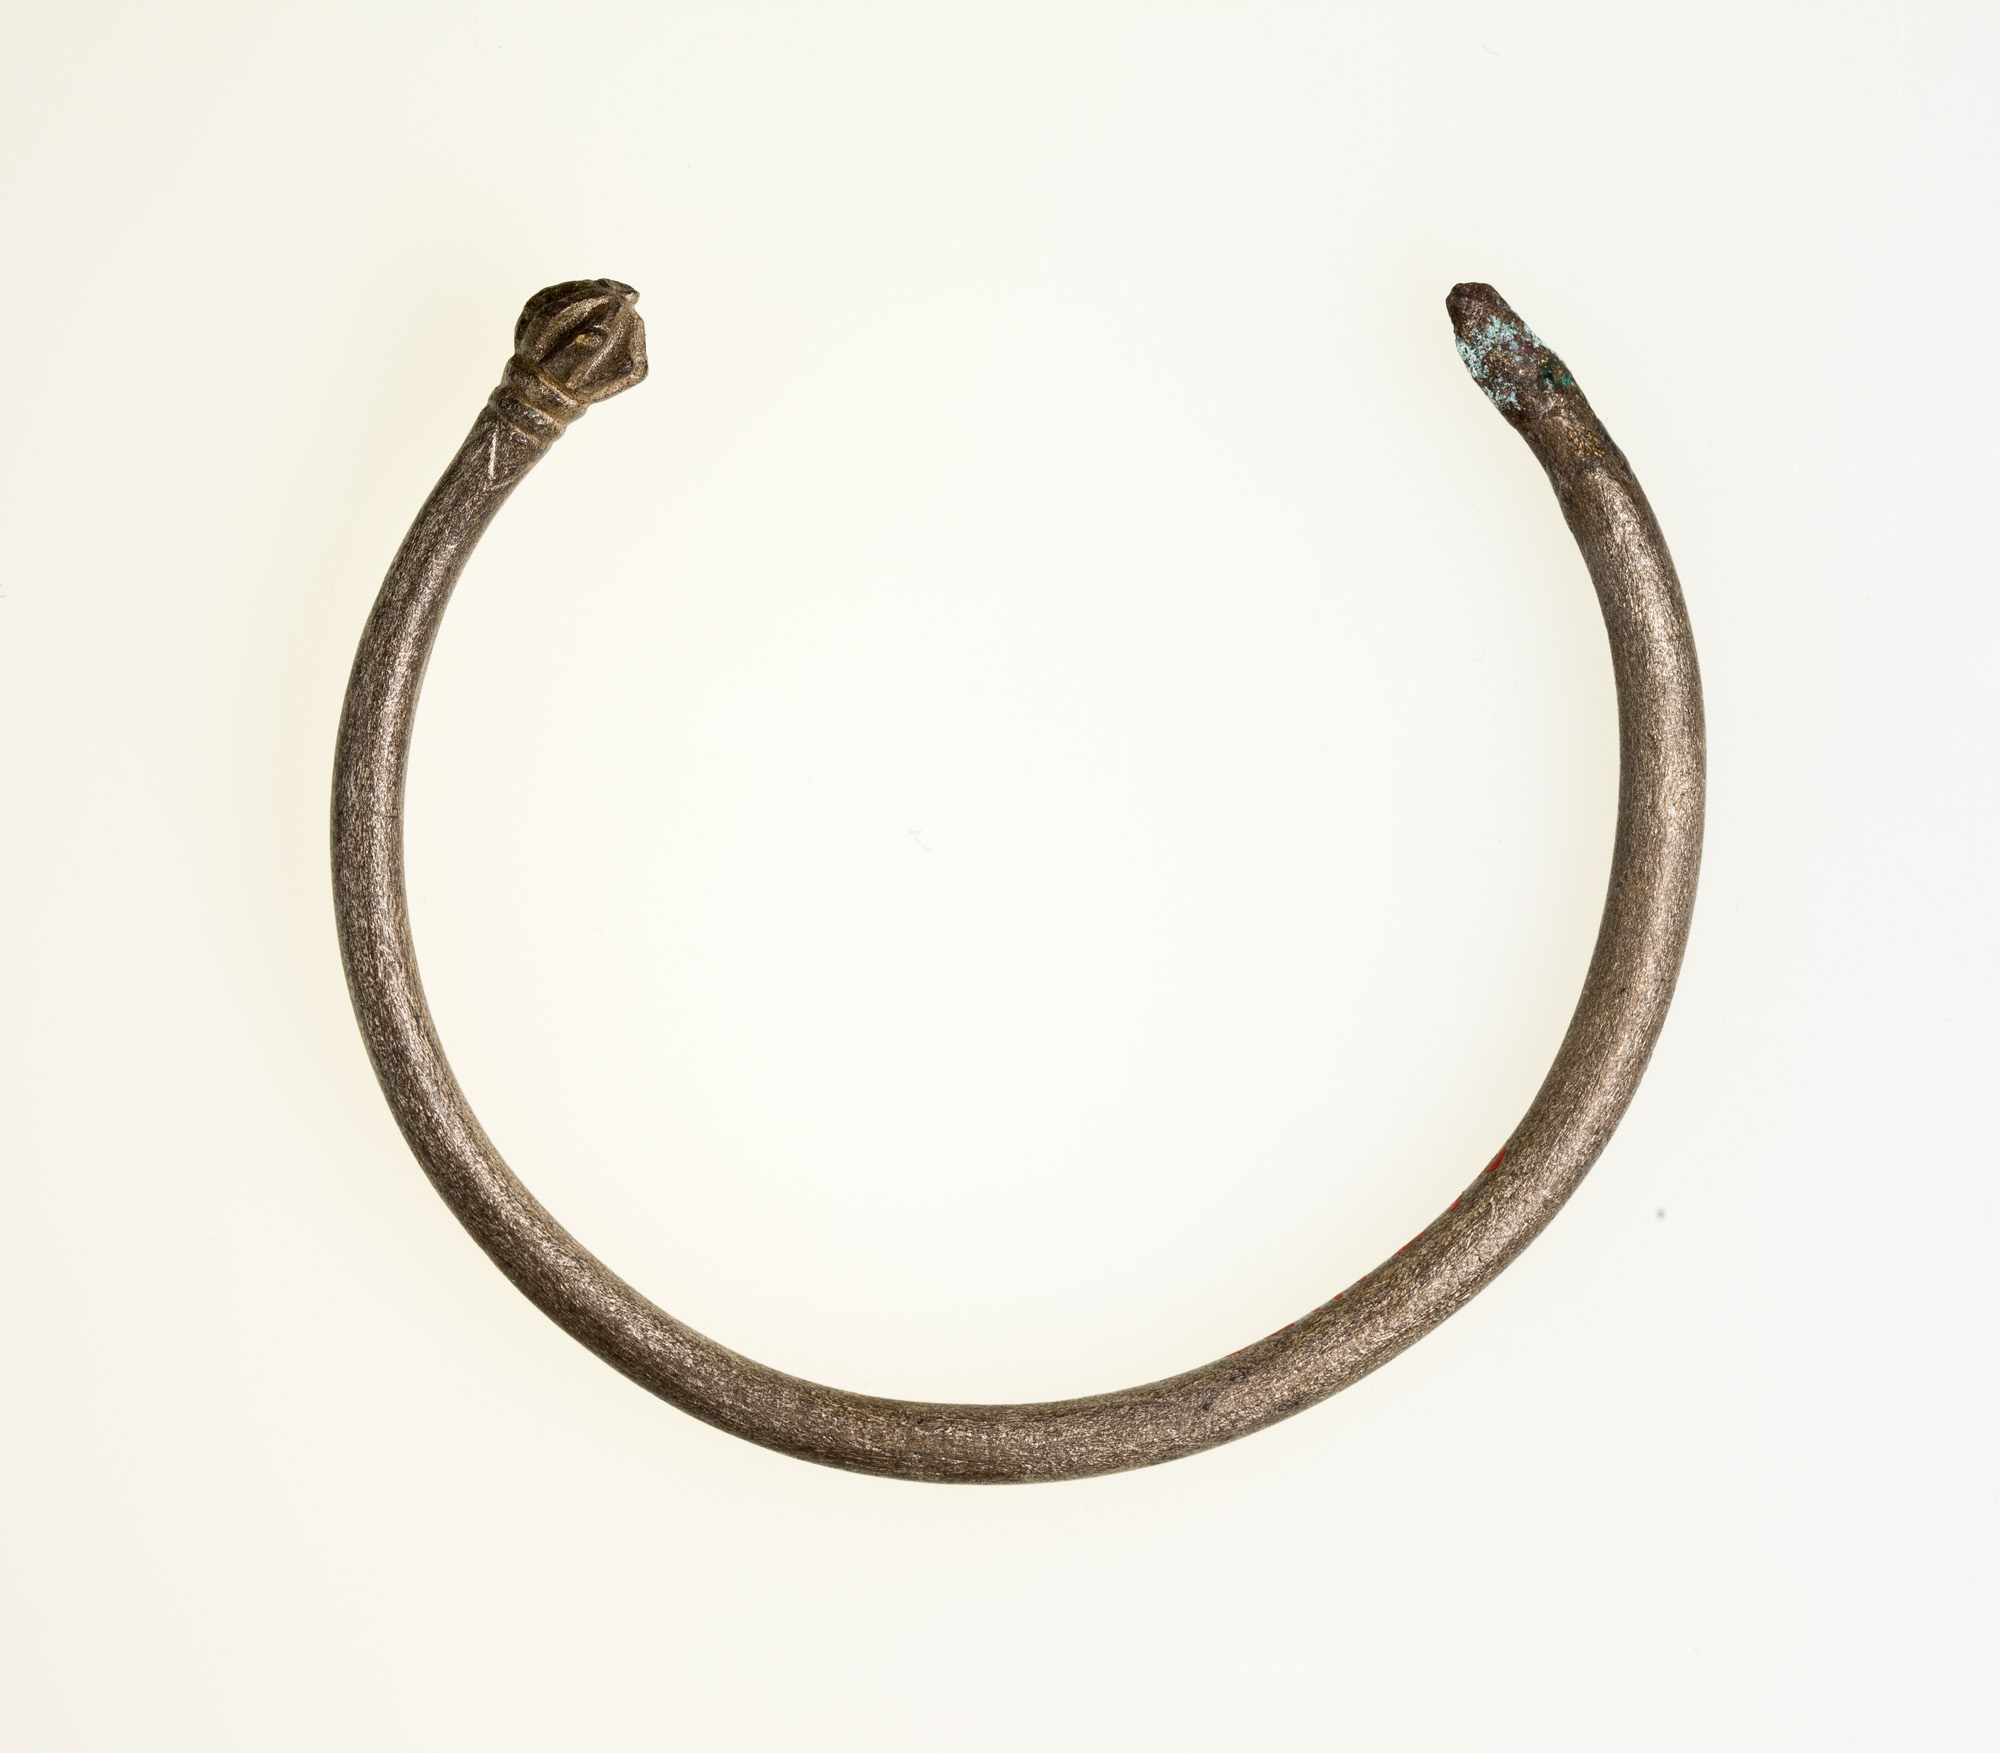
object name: bracelet bangle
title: Bangle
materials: silver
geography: egypt